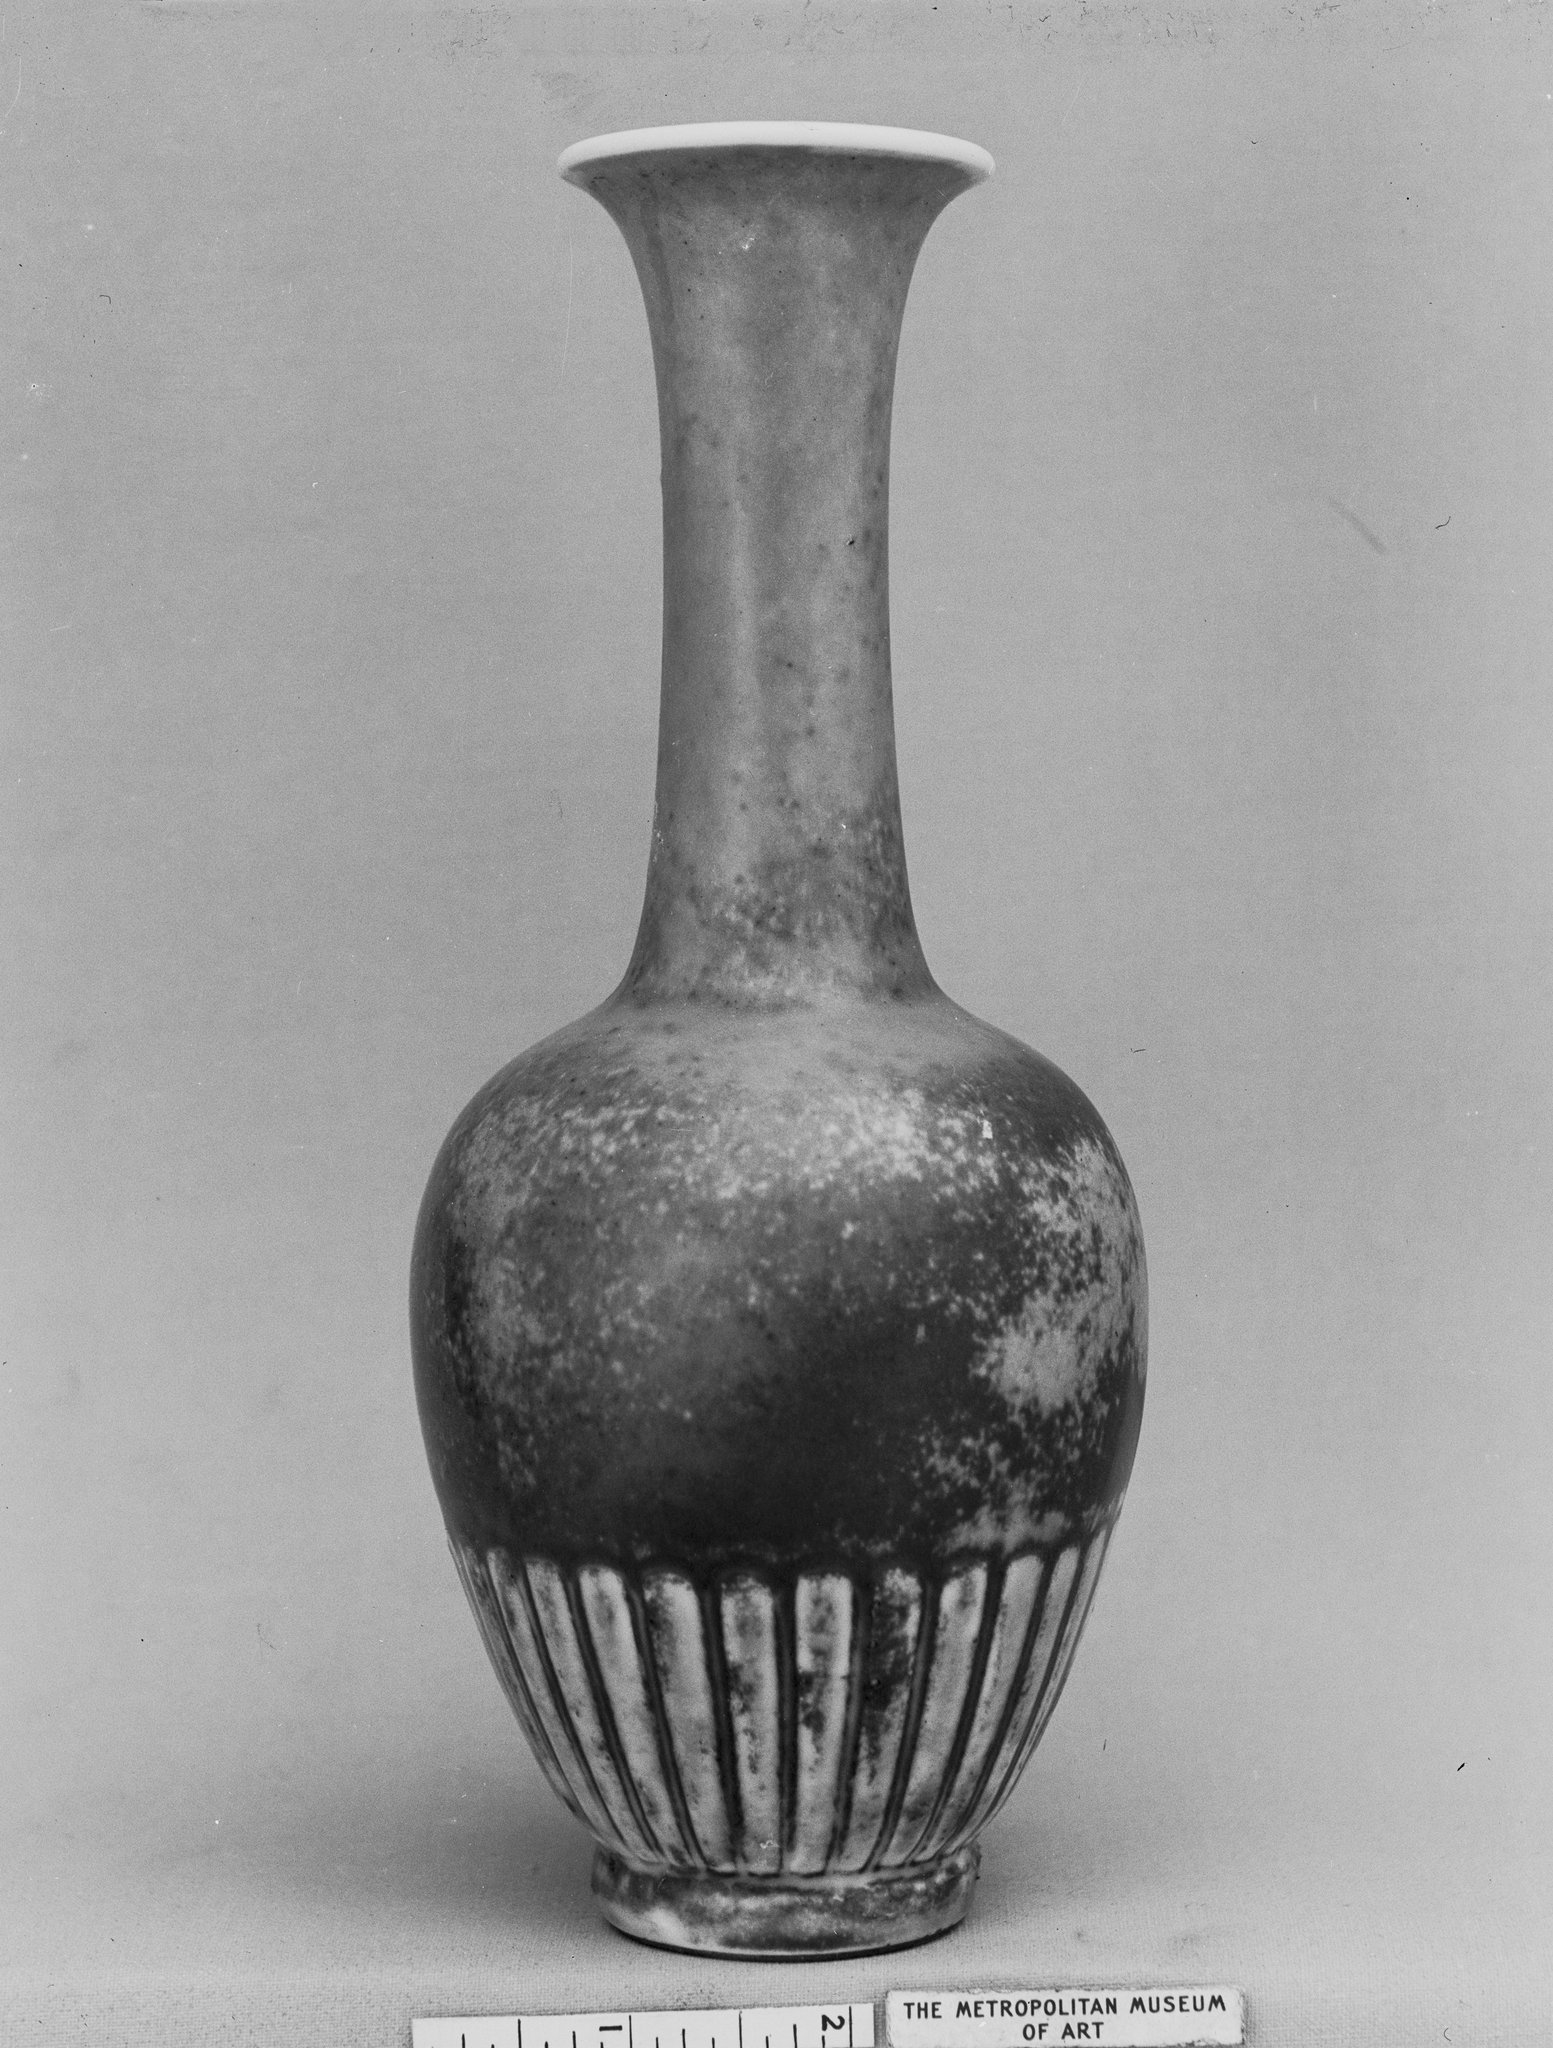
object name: vase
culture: chinese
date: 1662-1722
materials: porcelain